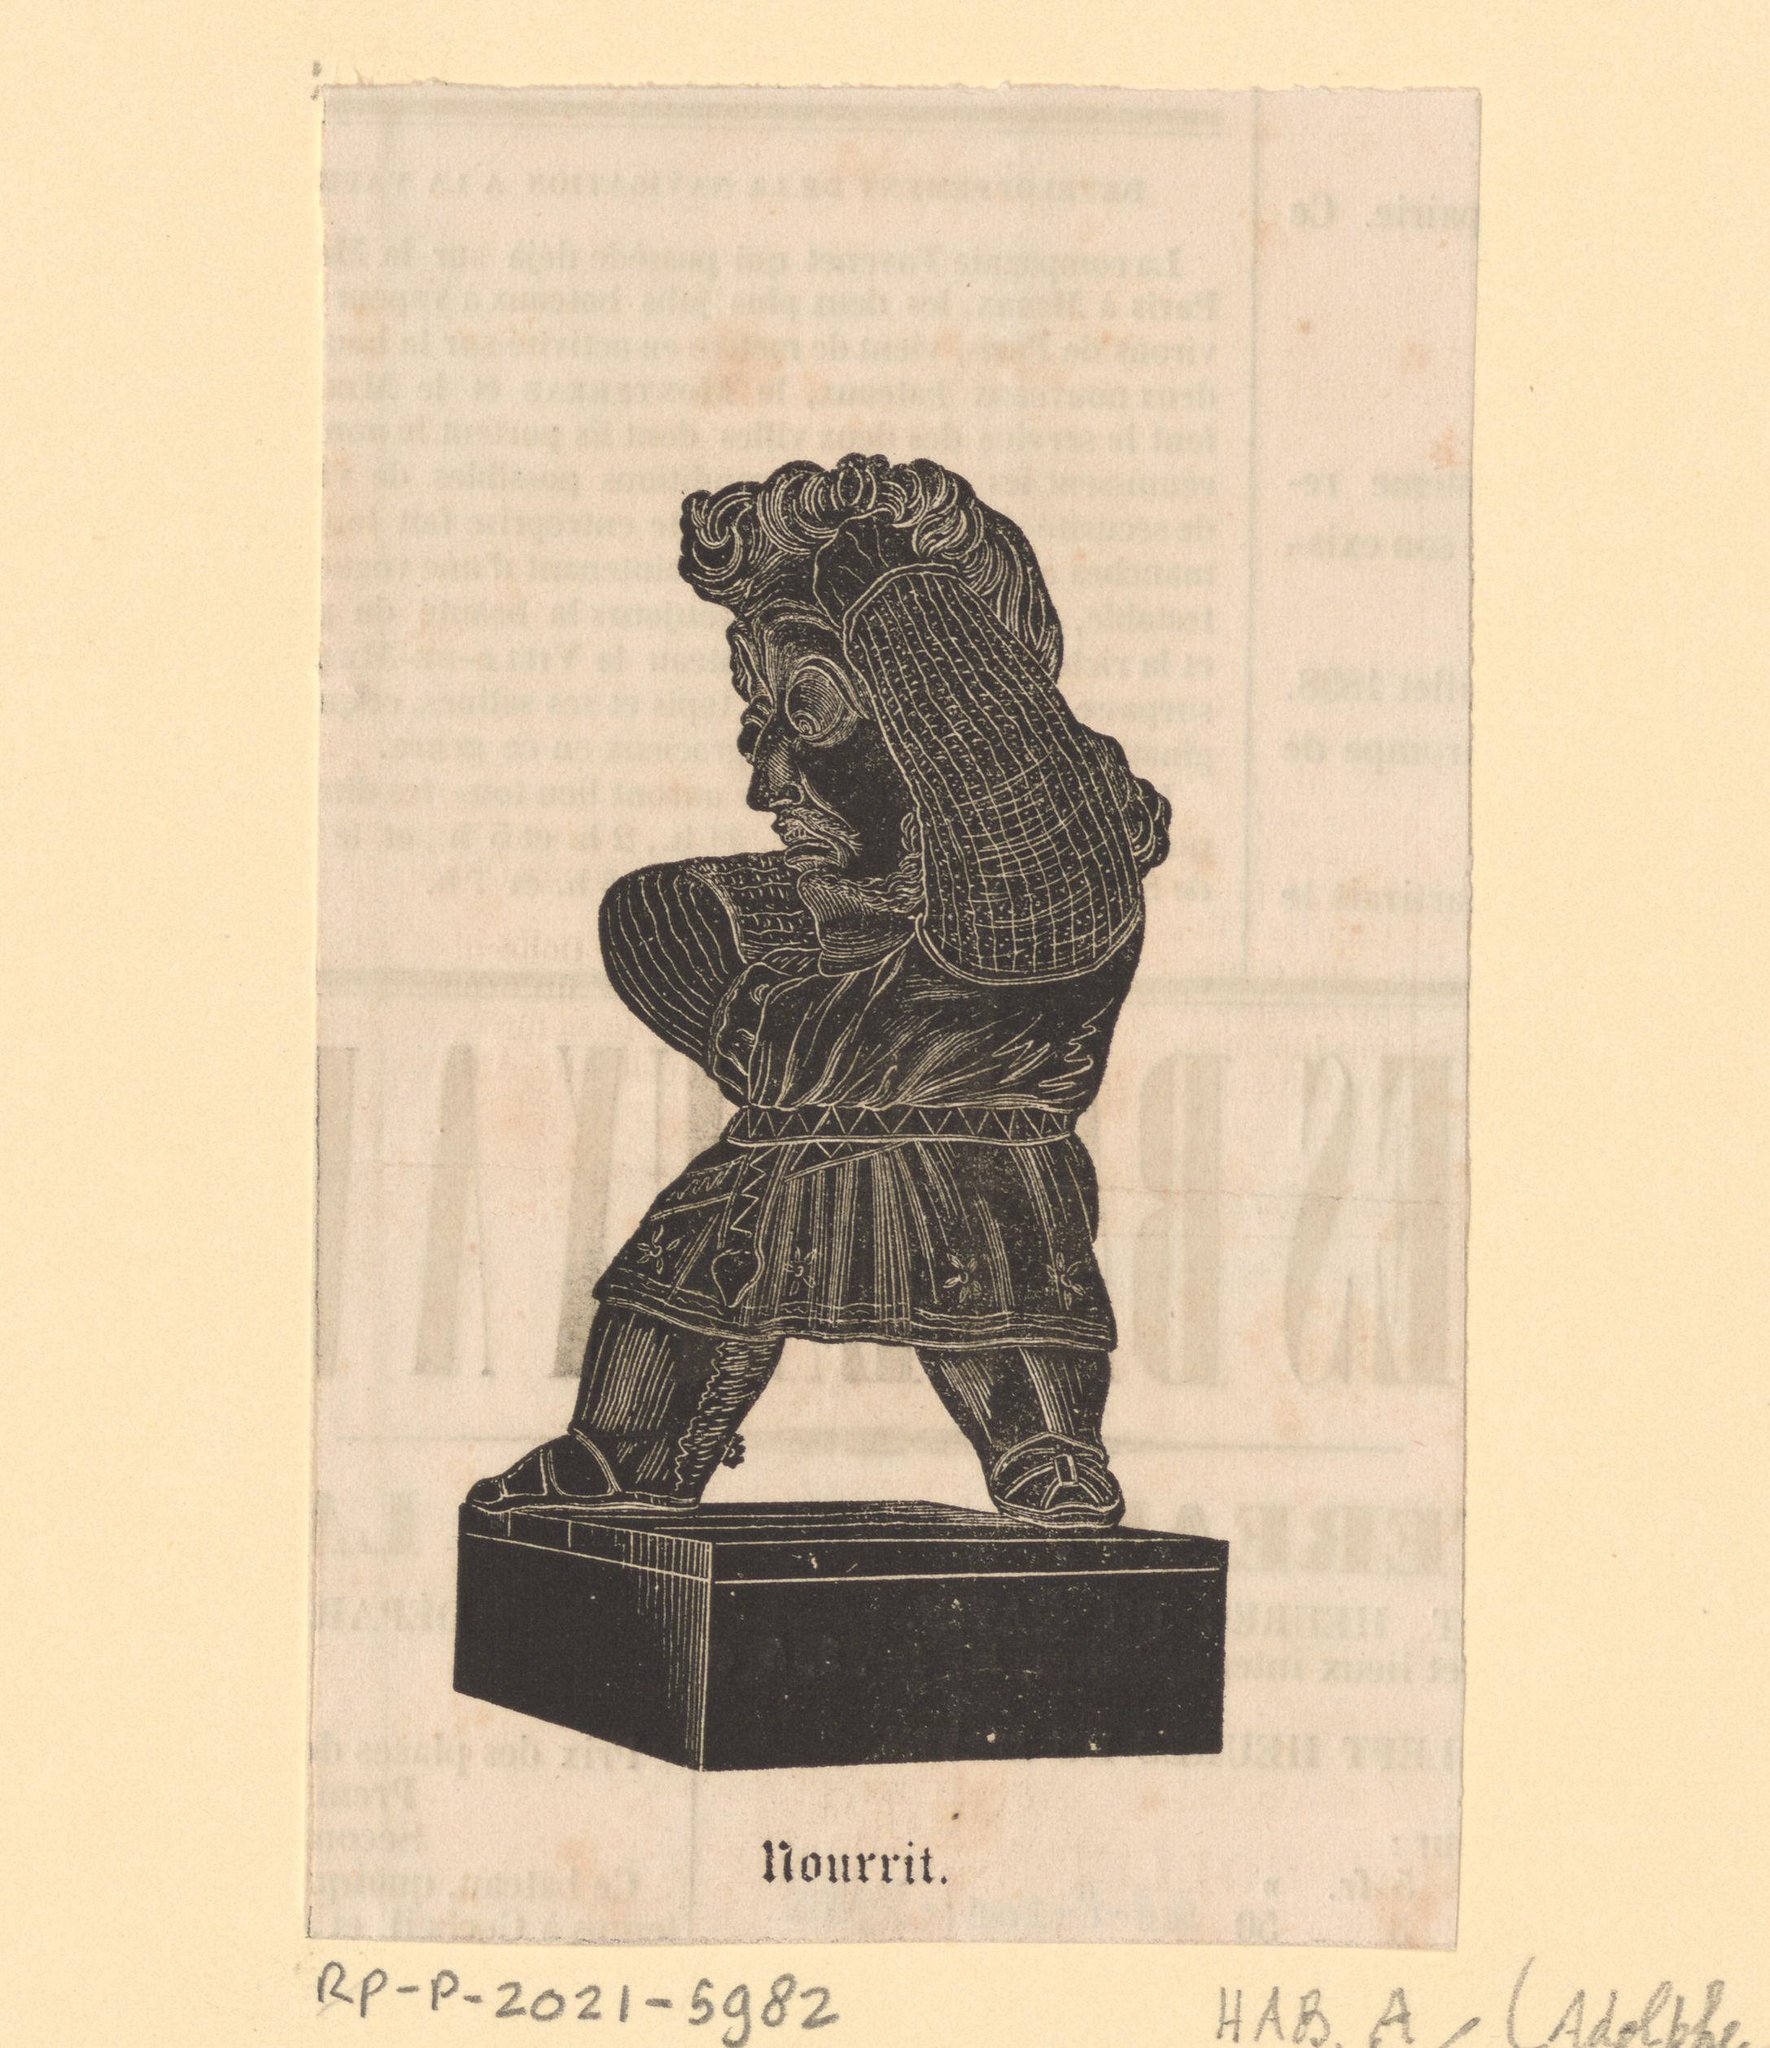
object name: print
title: Portret van Adolphe Nourrit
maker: Anonymous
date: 1839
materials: paper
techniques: letterpress printing, engraving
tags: caricatures (human types), historical persons, opera-singer (male)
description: Prent zonder tekst op verso gebruikt in: Musée Dantan. Galerie des charges et croquis des célébrités de l'époque (...). Parijs: Henri Delloye, 1839.